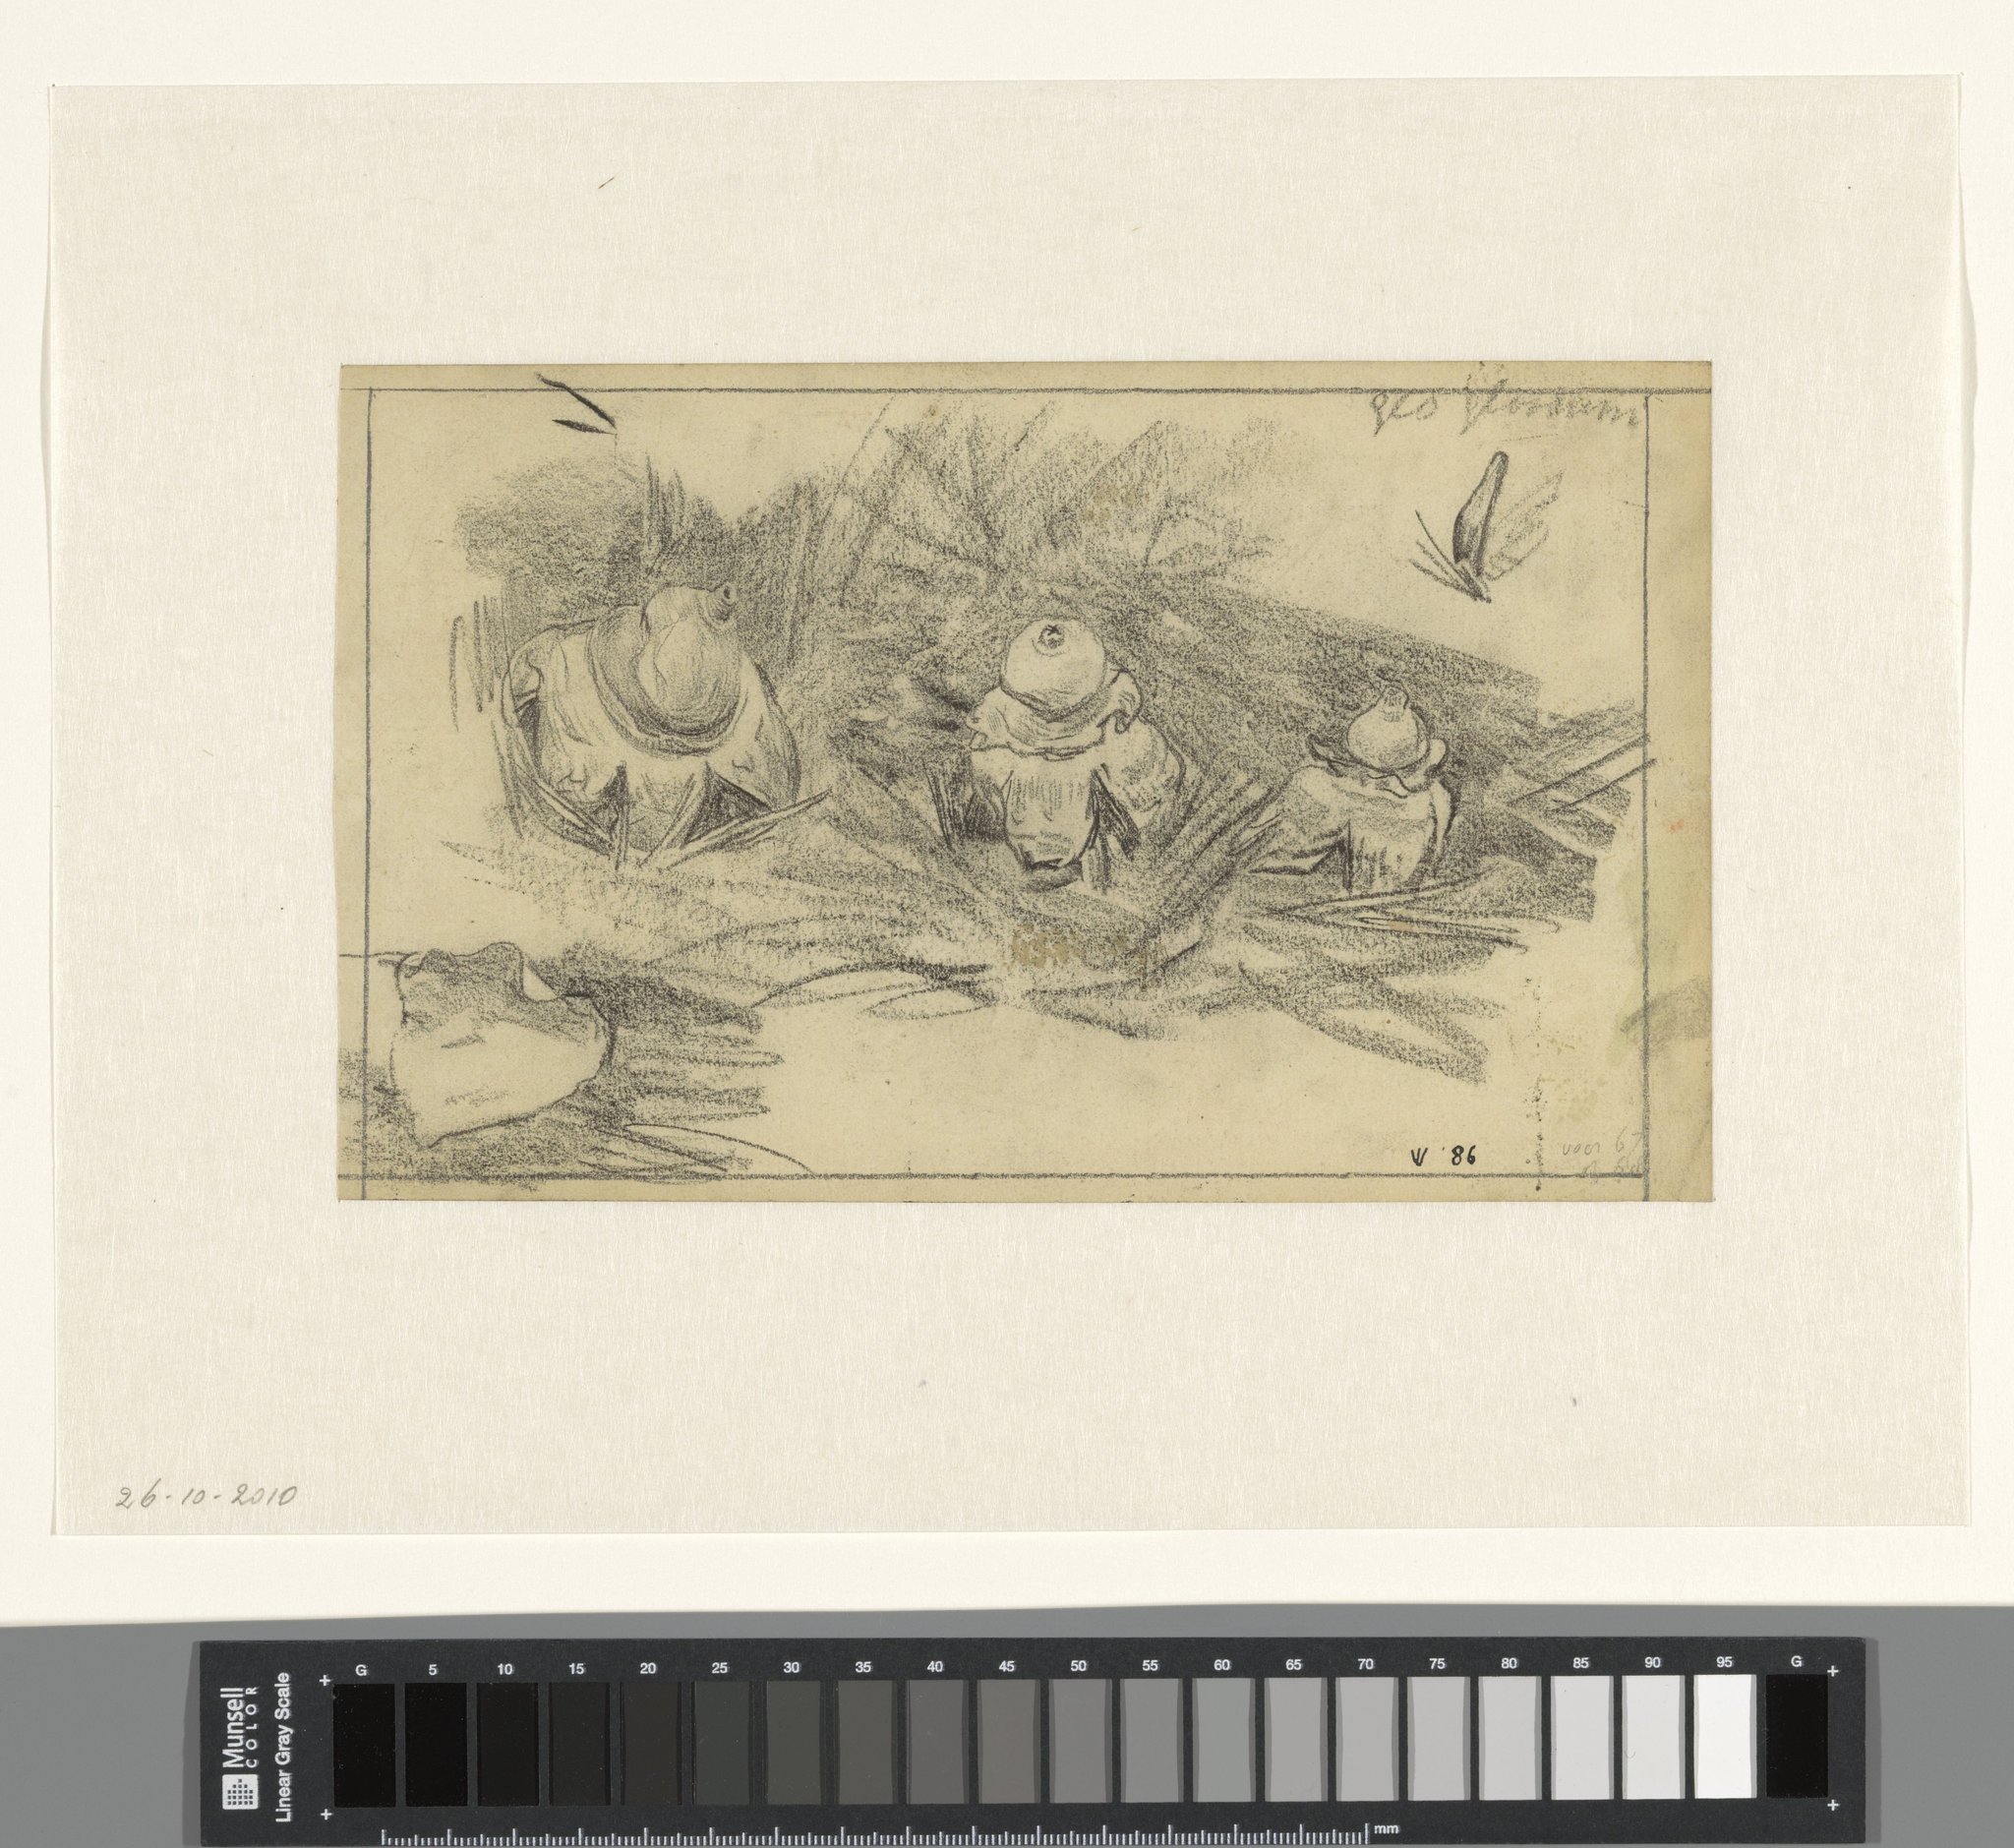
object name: drawing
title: Aardsterren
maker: jan veth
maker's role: designer, draughtsman, painter, print maker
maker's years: 1864-1925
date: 1886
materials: chalk, paper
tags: mushrooms